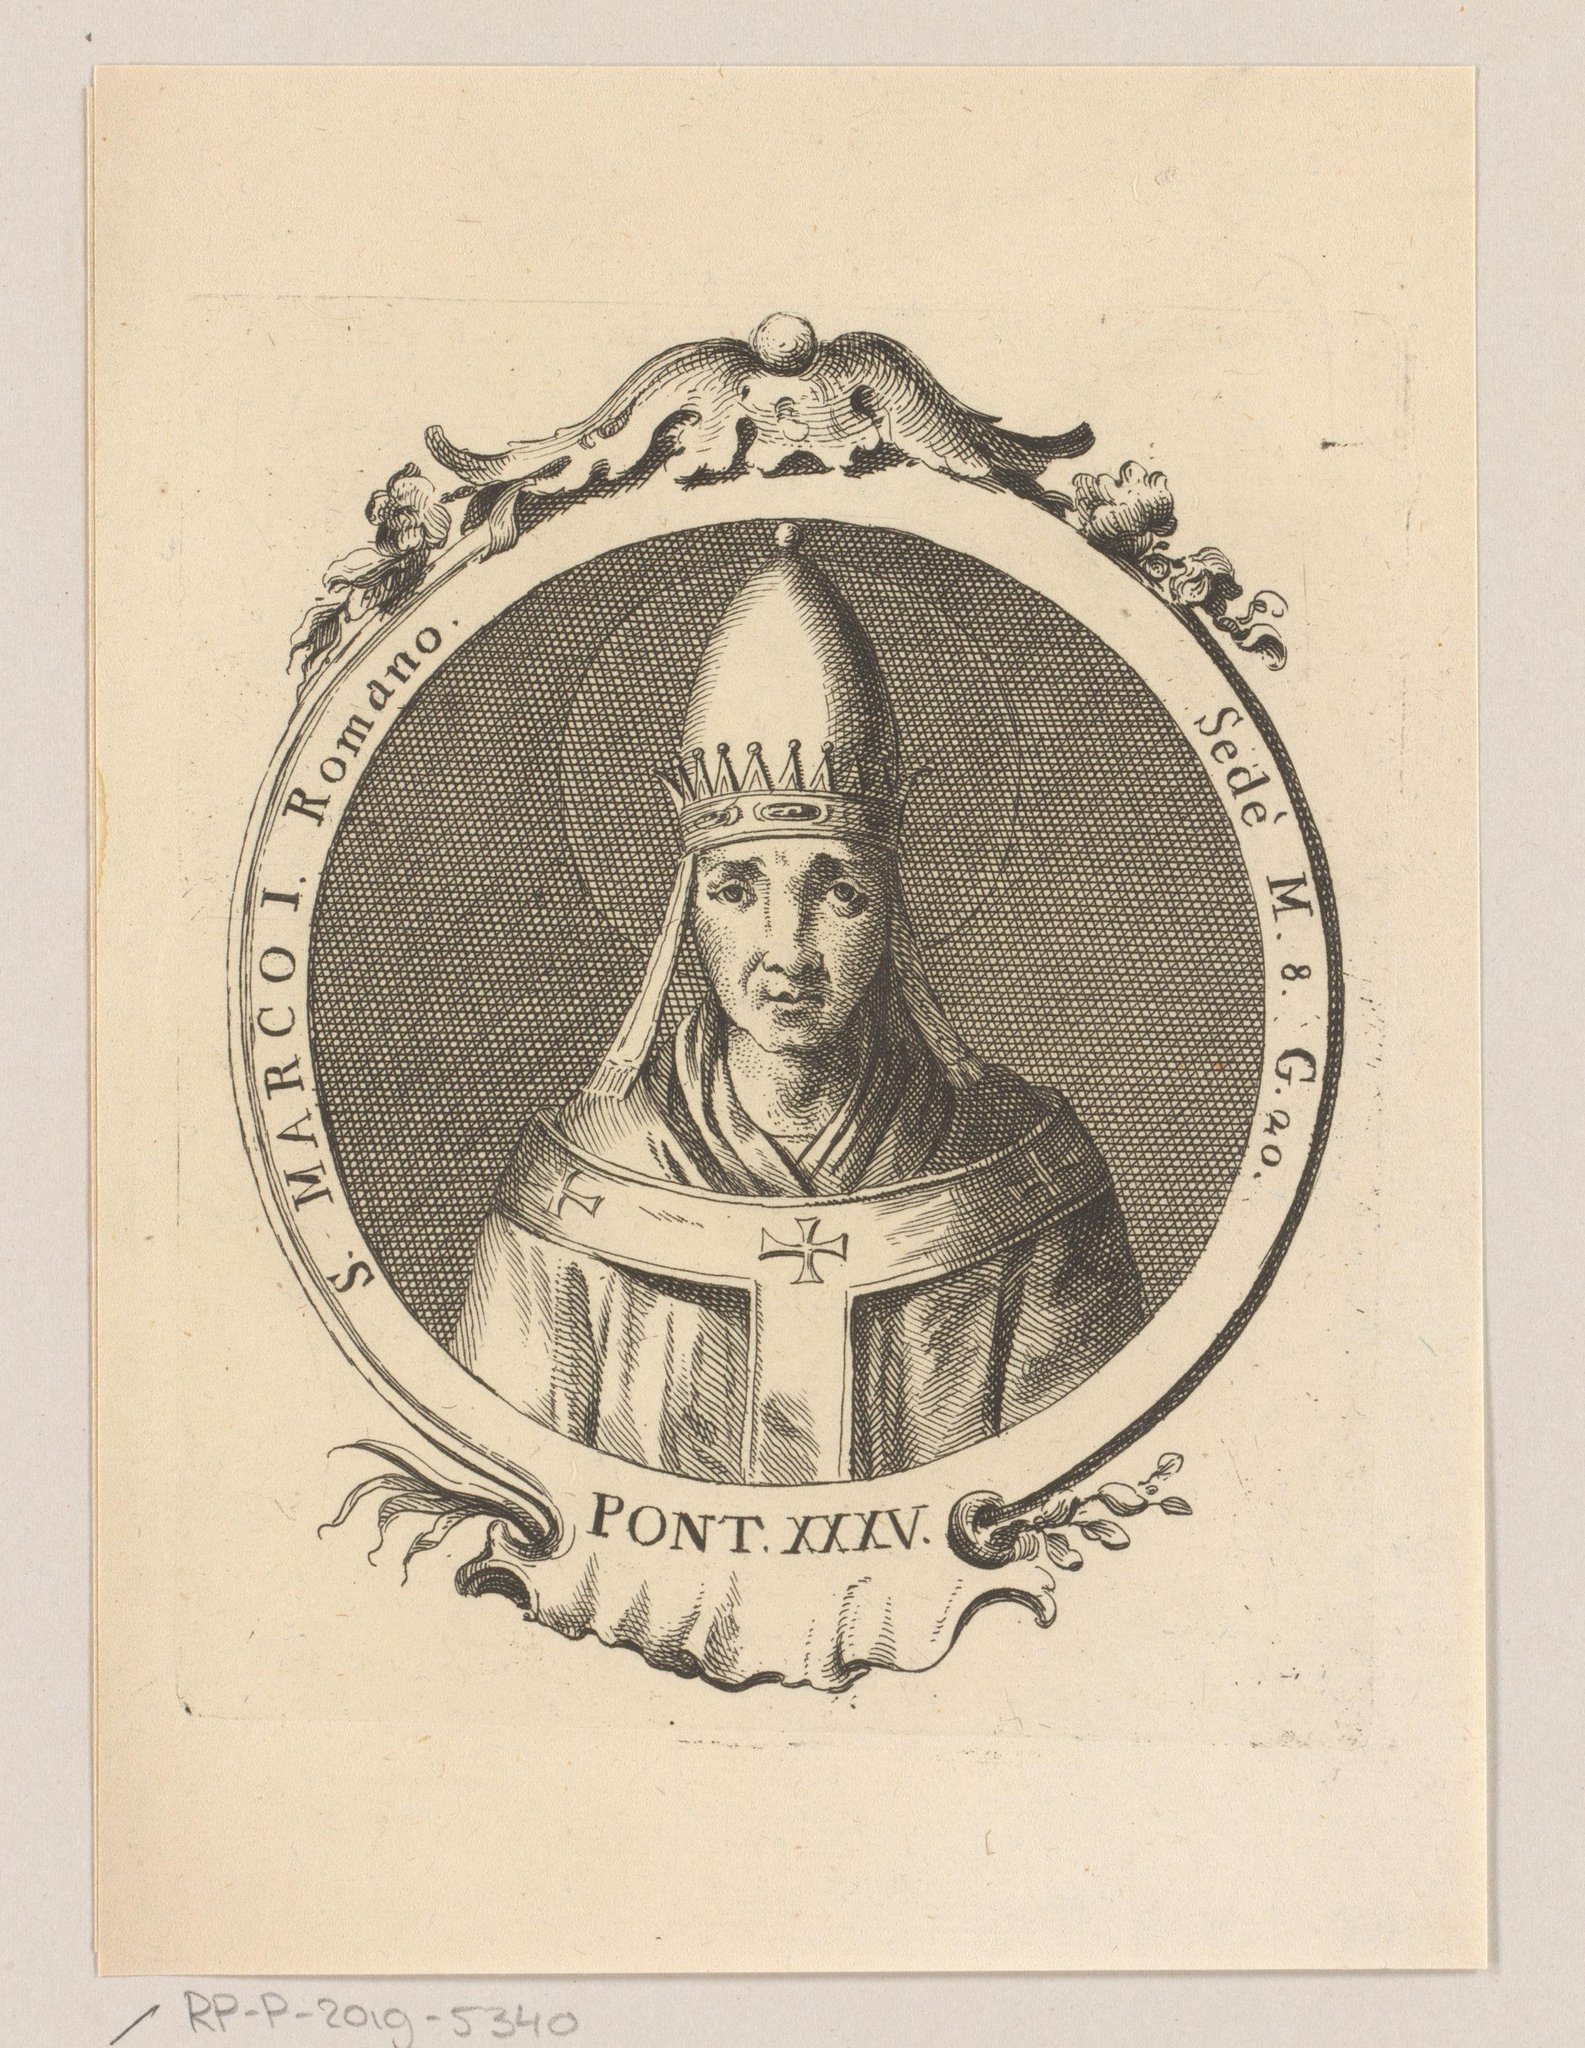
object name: book illustration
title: Portret van paus Marcus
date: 1775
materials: paper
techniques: engraving, etching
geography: venice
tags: rome, historical persons, pope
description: Prent uit: Effigies Romanorum pontificum a S. Petro ad Pium VI. feliciter regnantem (...). 2 dln. Venetië en Bassano del Grappa: Giuseppe Remondini, 1775.